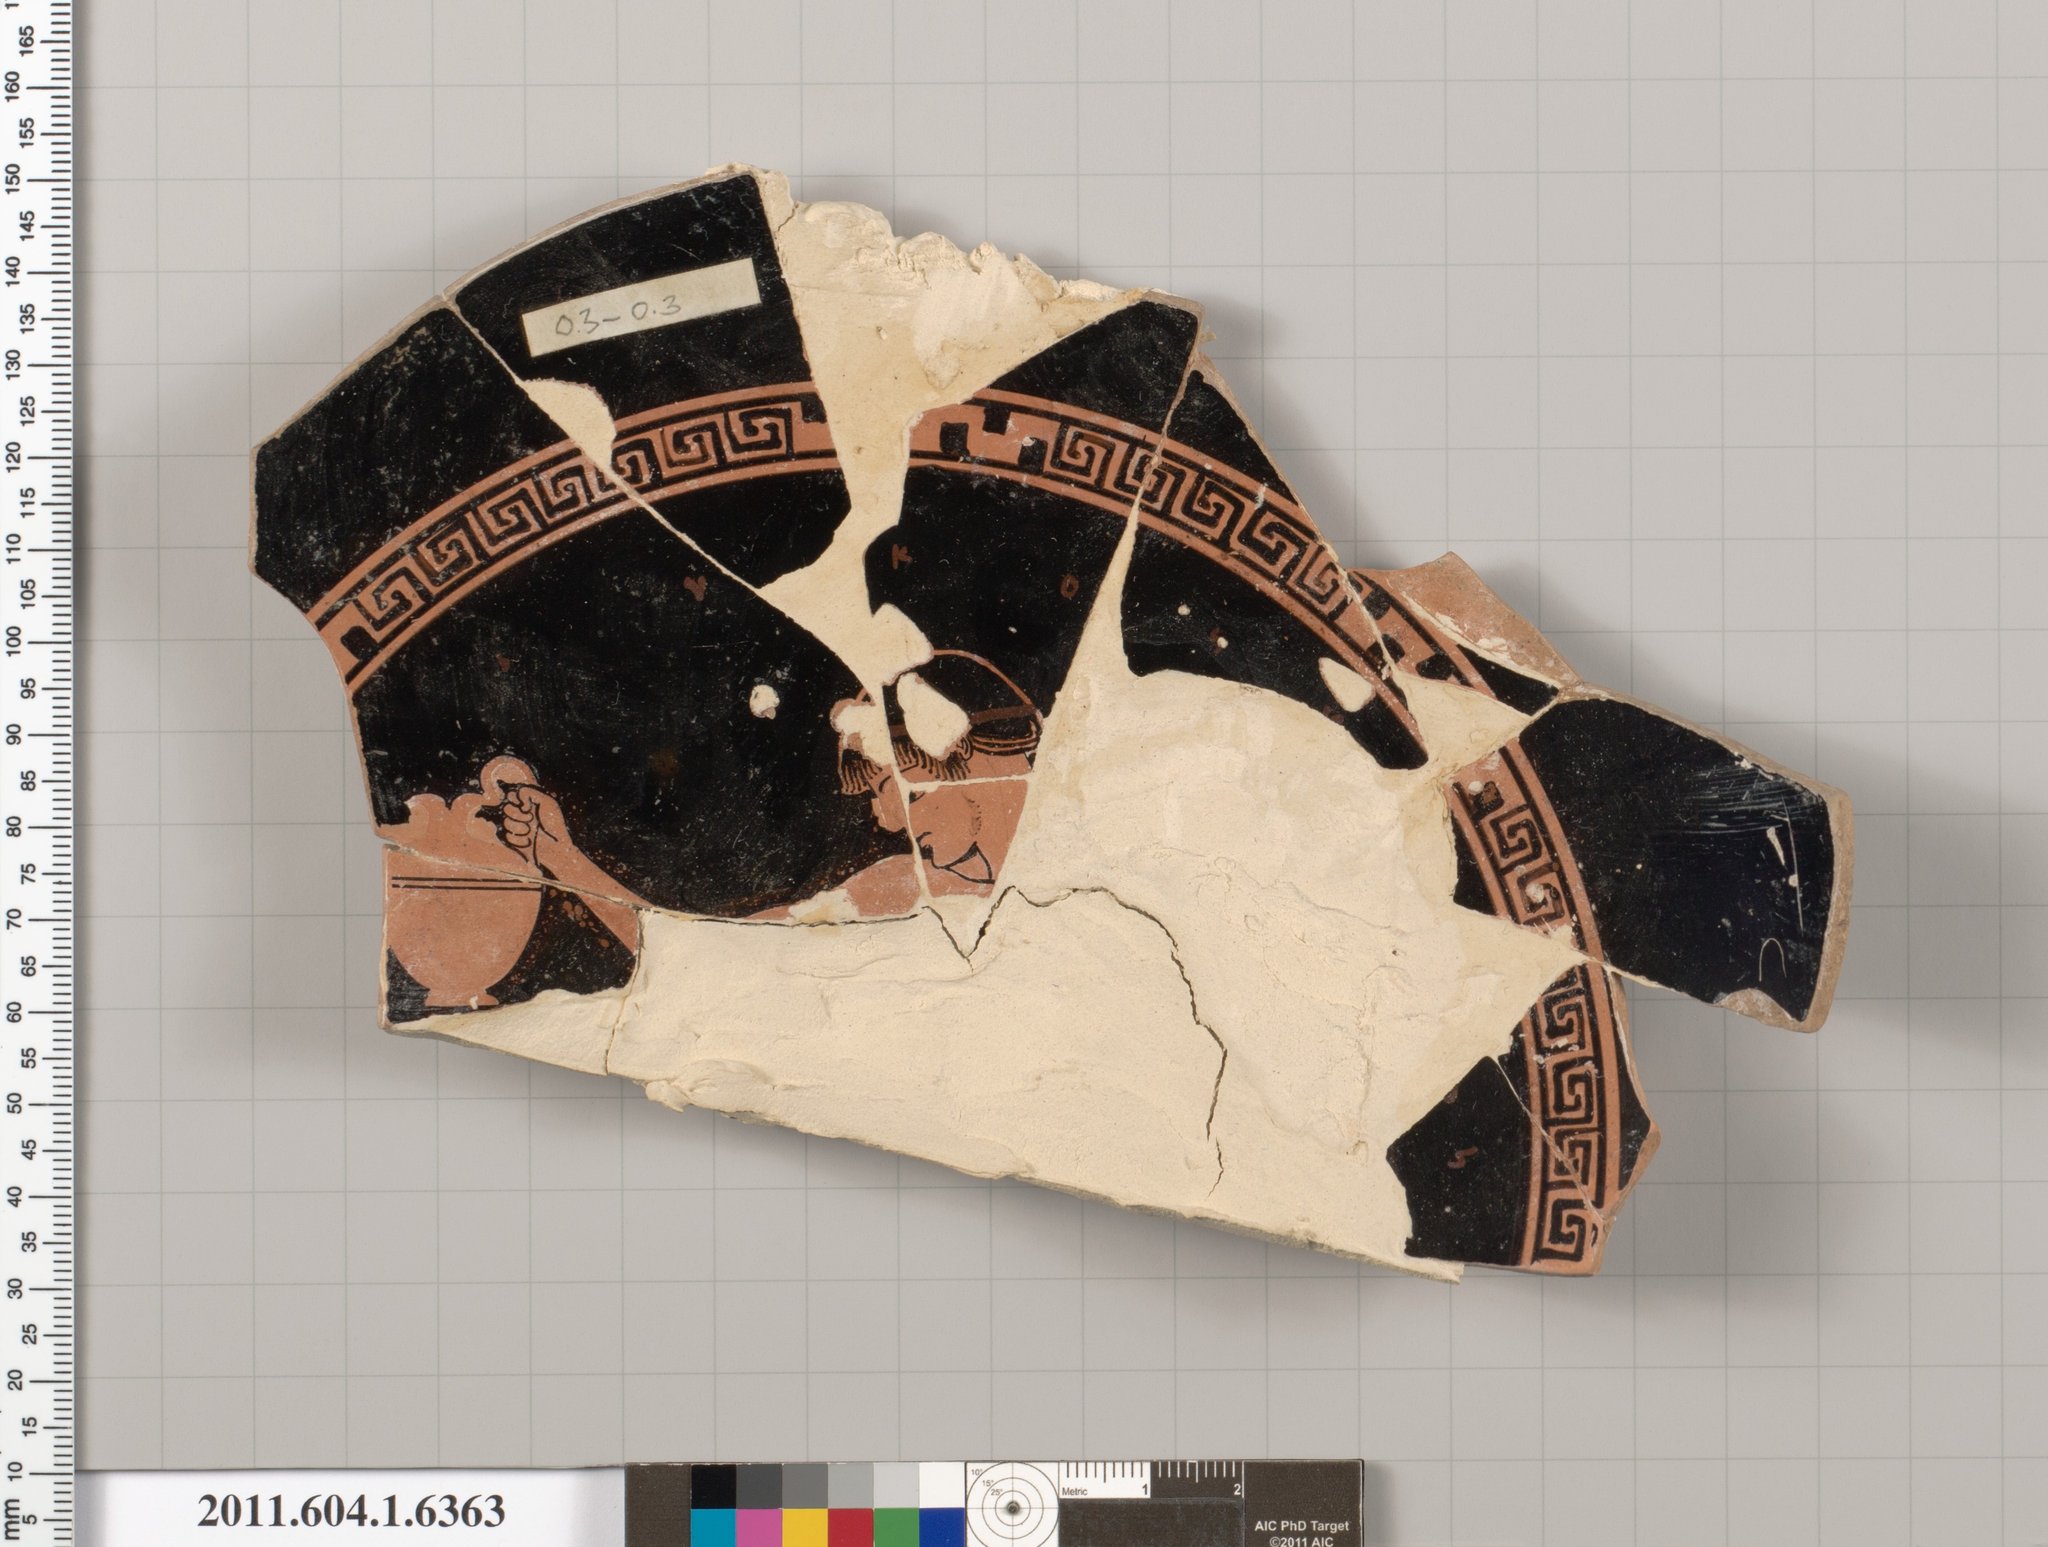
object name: kylix fragment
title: Terracotta fragment of a kylix (drinking cup)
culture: greek, attic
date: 490-480 BCE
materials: terracotta